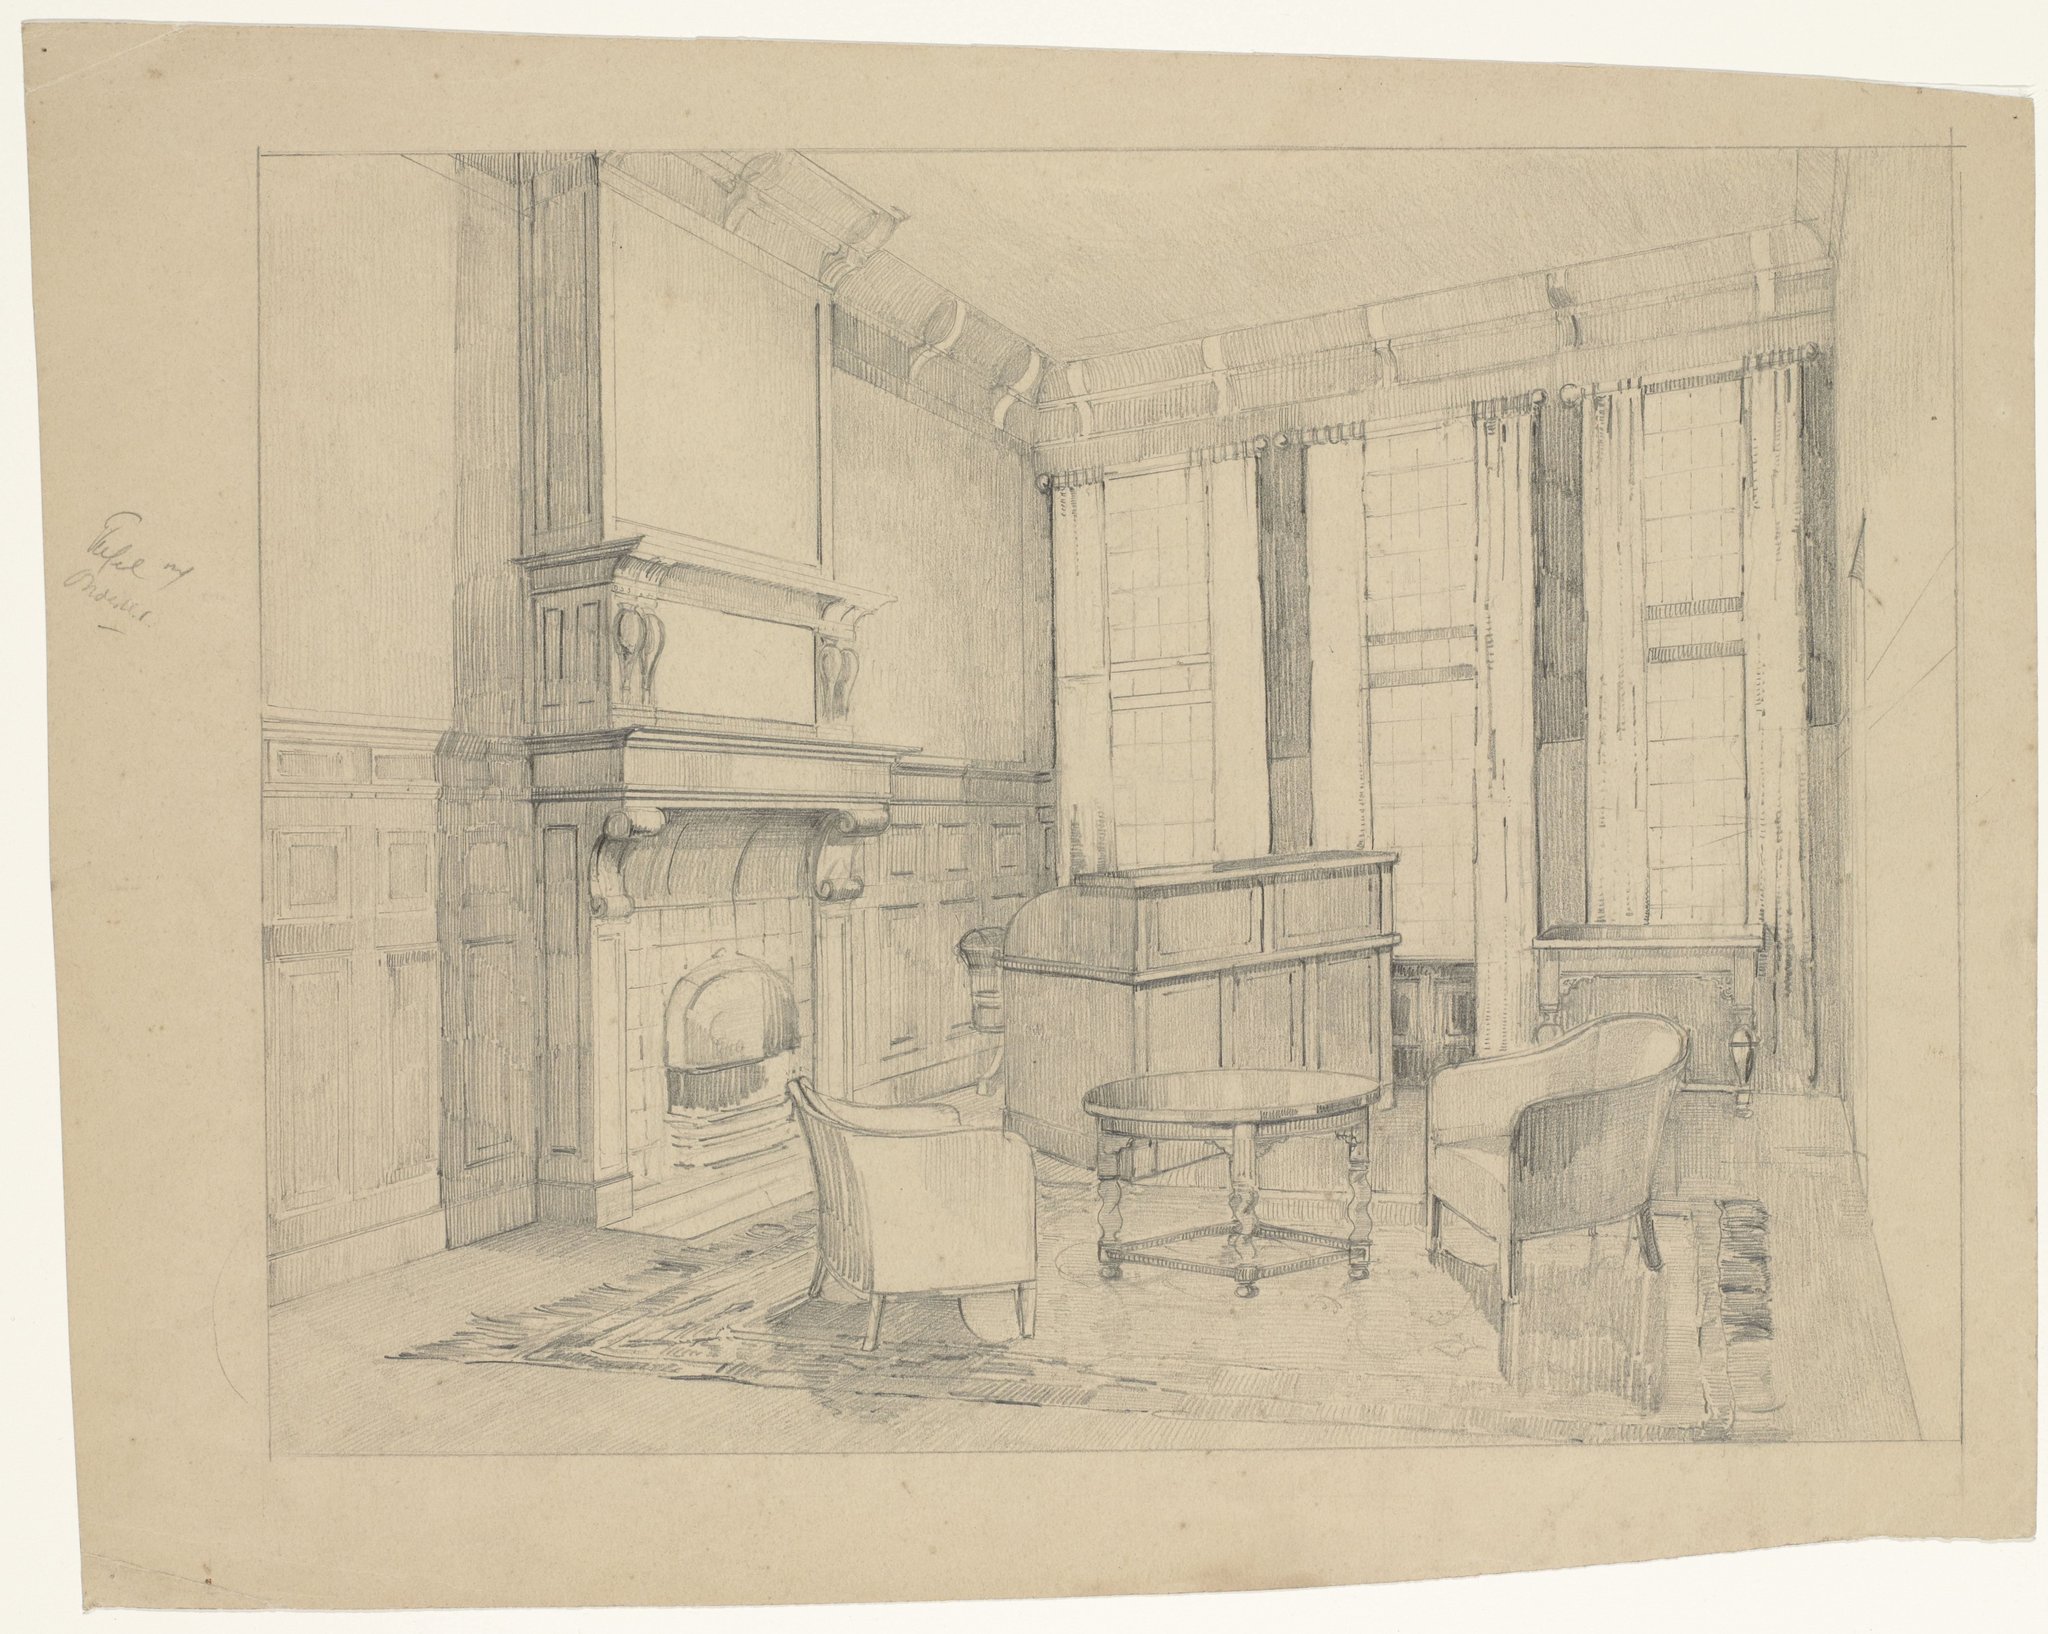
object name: drawing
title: Interieur van studeerkamer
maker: Anonymous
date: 1920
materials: paper, pencil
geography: netherlands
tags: study; 'studiolo'; library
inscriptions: inscription: ‘Tafel nog [?] / onder [..]’